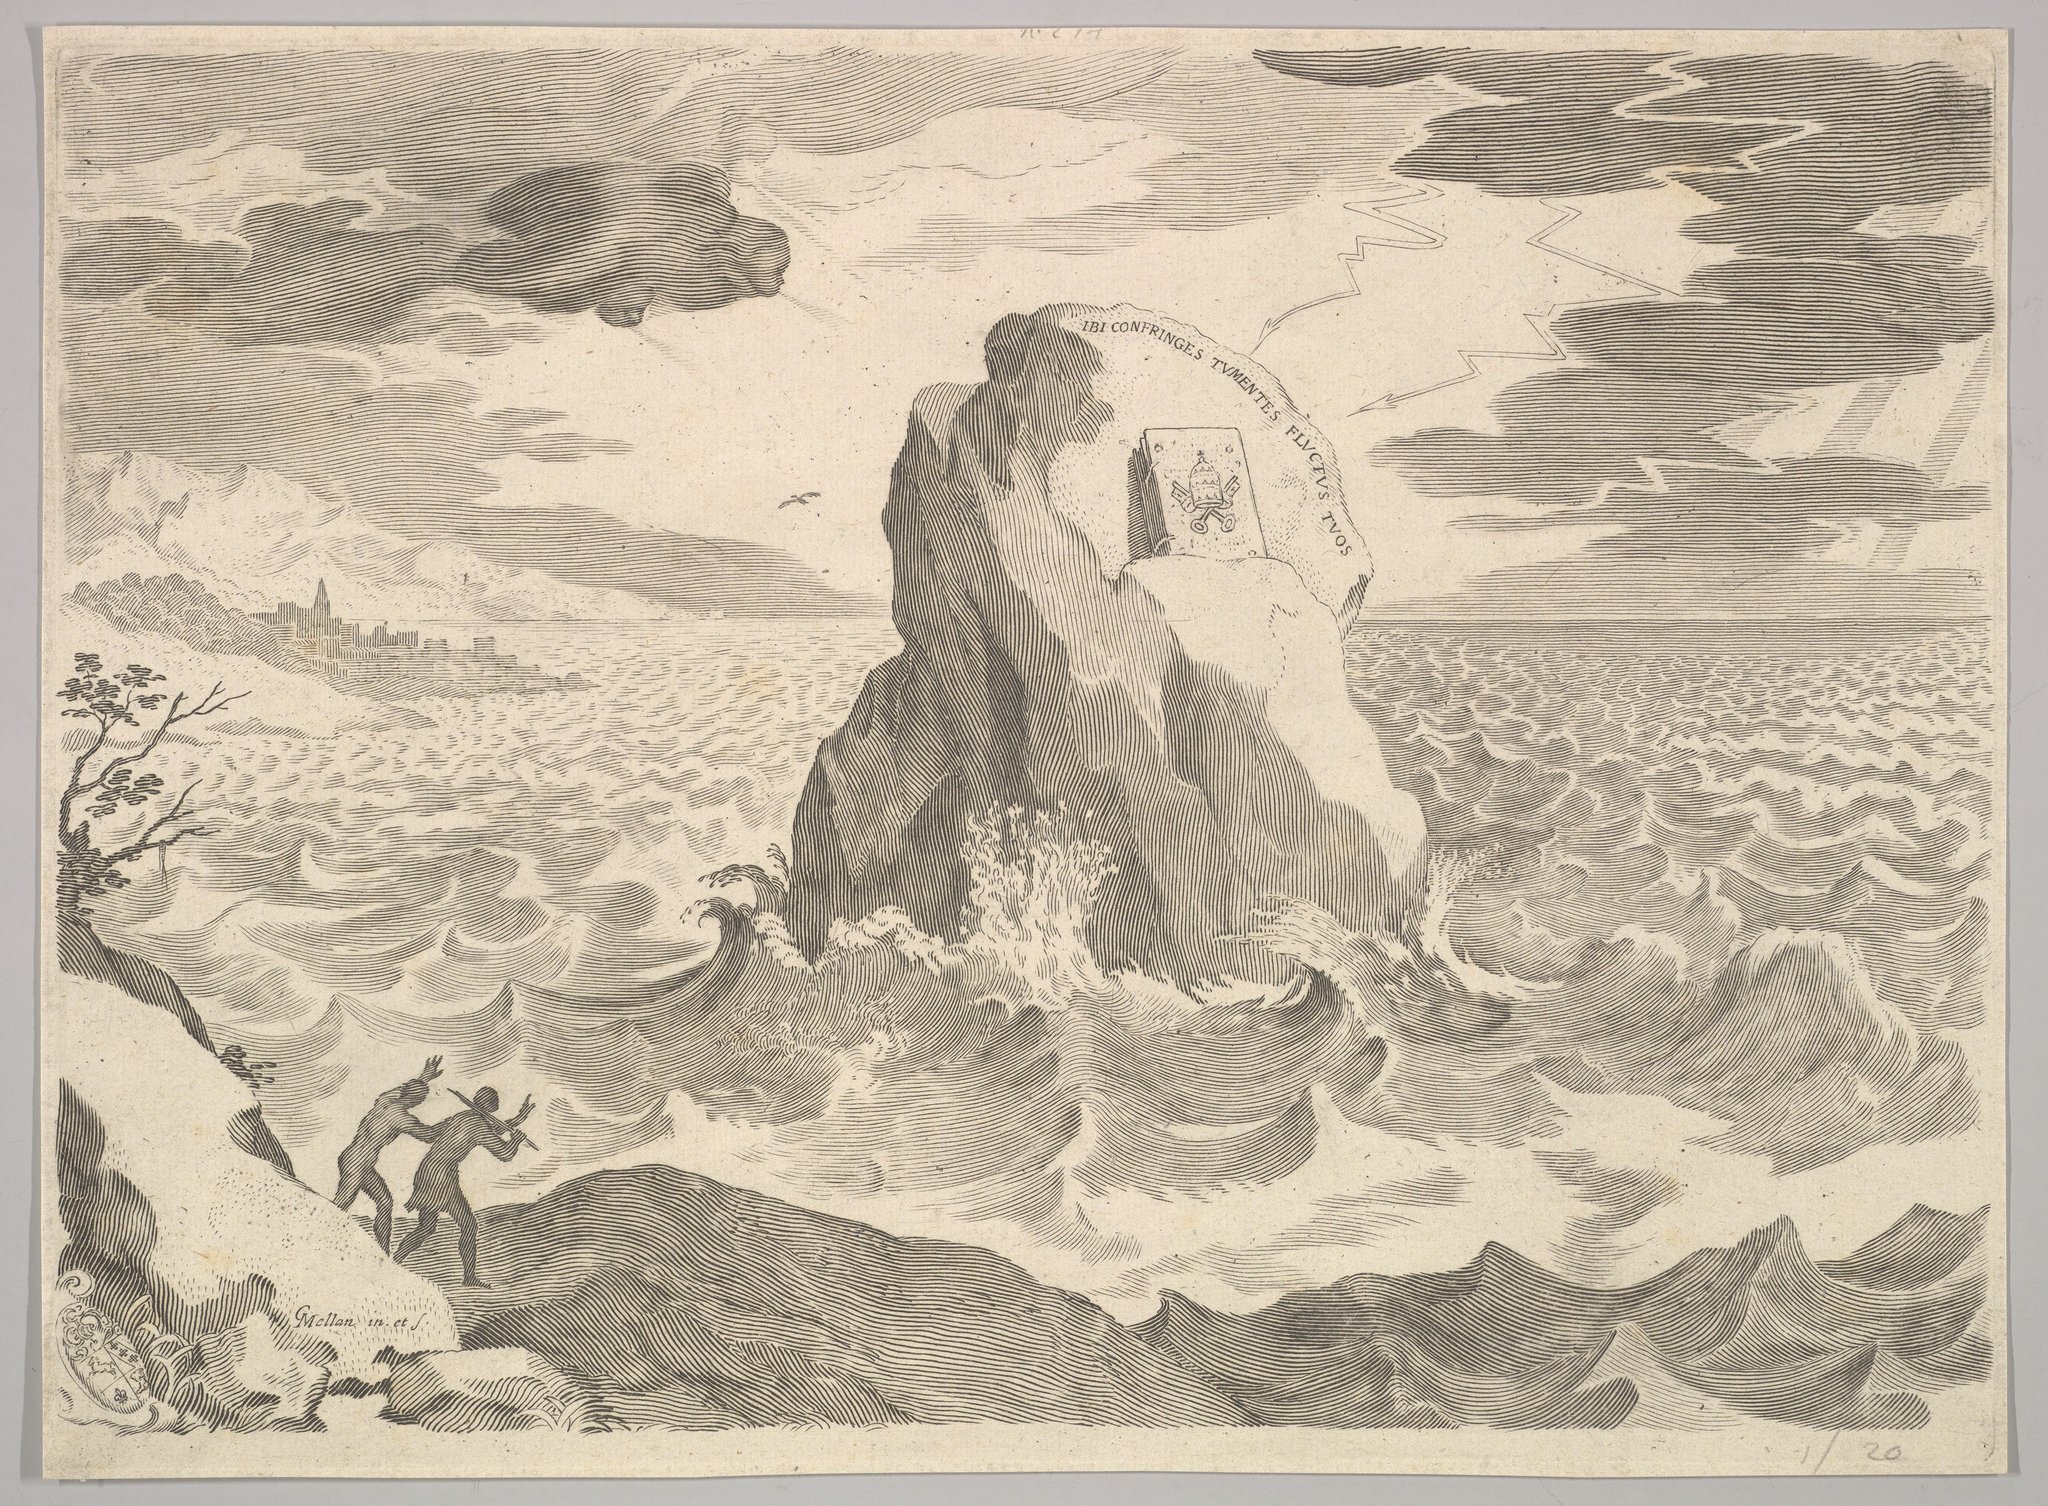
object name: print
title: Allegory Against the Pelagian Heresy (Allégorie contre l'hérésy pélagienne et armoires)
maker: claude mellan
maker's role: artist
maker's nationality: french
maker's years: 1598-1688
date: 1601-1700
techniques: engraving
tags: landscapes,waves